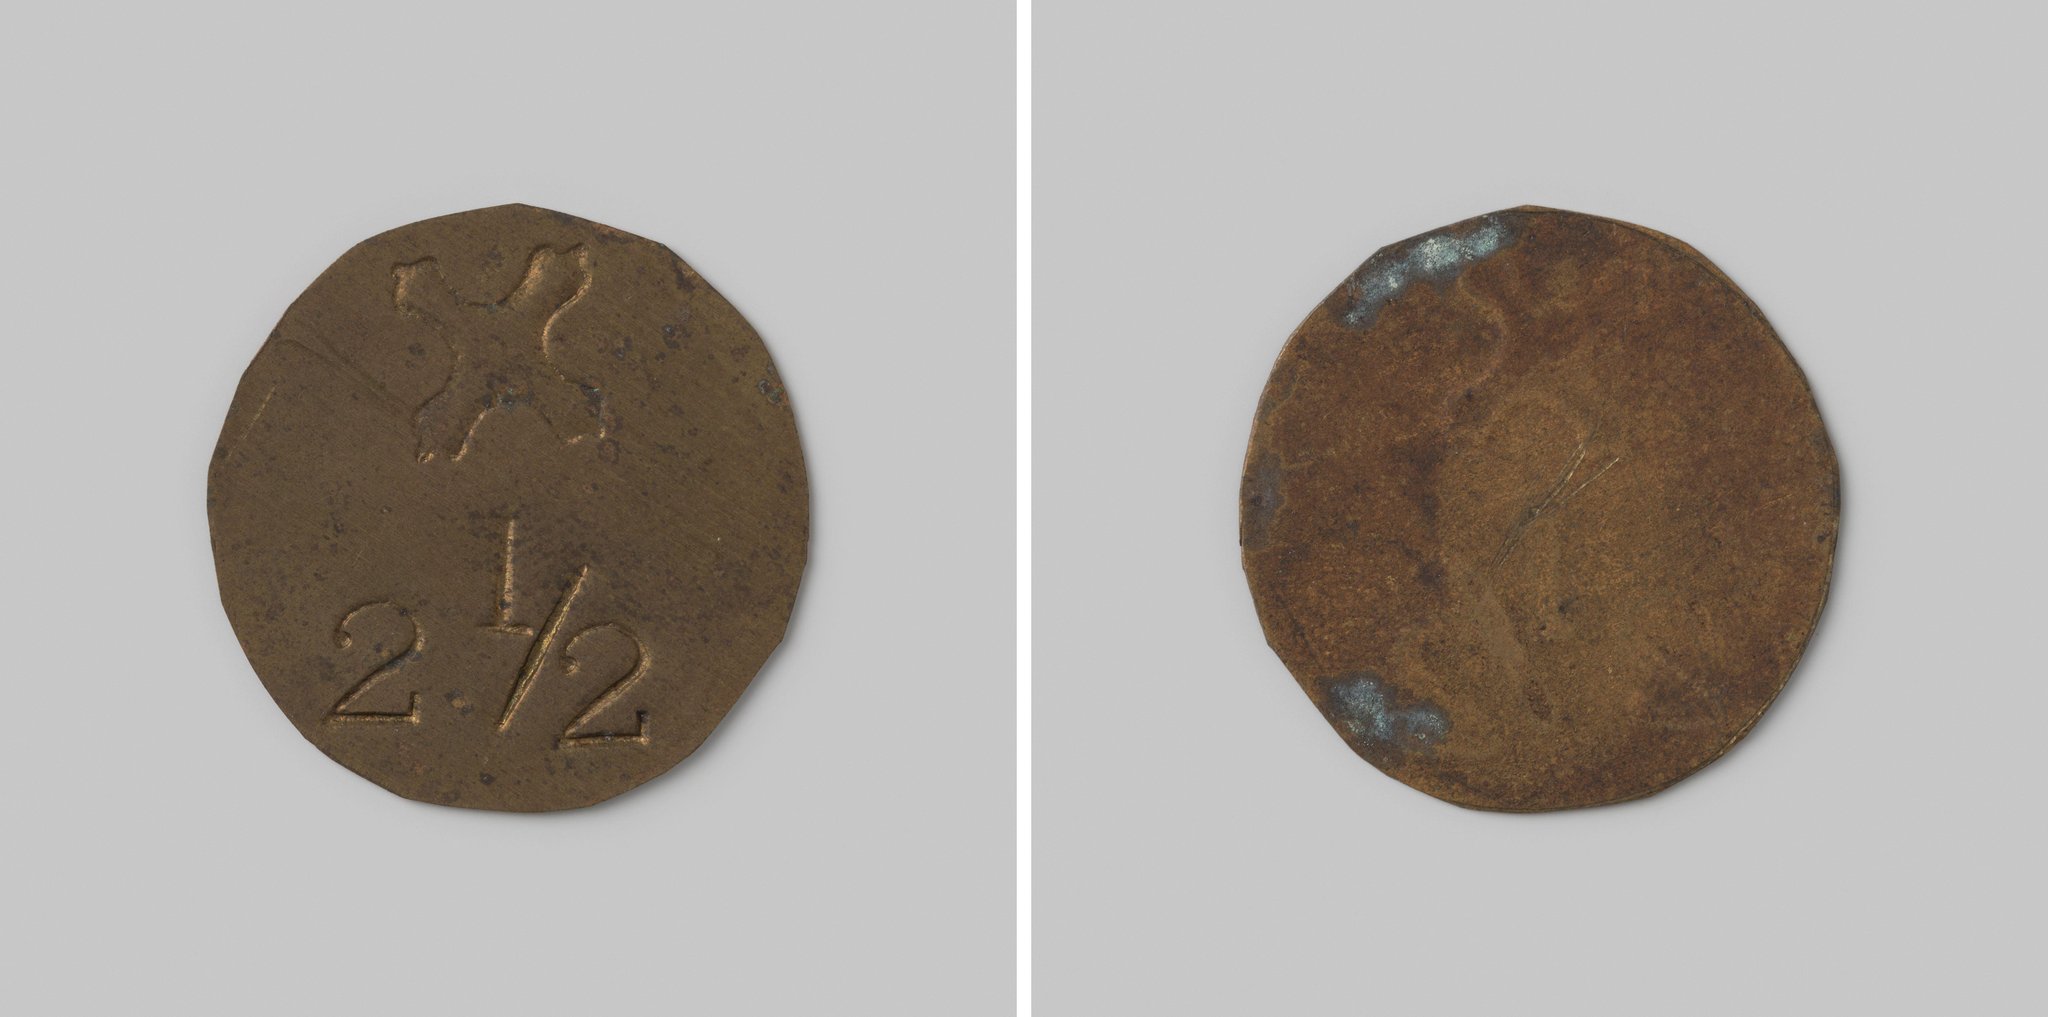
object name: twee en een halve cent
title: Betaalpenning van tweeënhalve cent van de Coöperatieve Winkelvereeniging De Volharding te Veenendaal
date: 1875-1900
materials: brass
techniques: printing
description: Rond messing plaatje met instempelingen (andreaskruis) / 2½